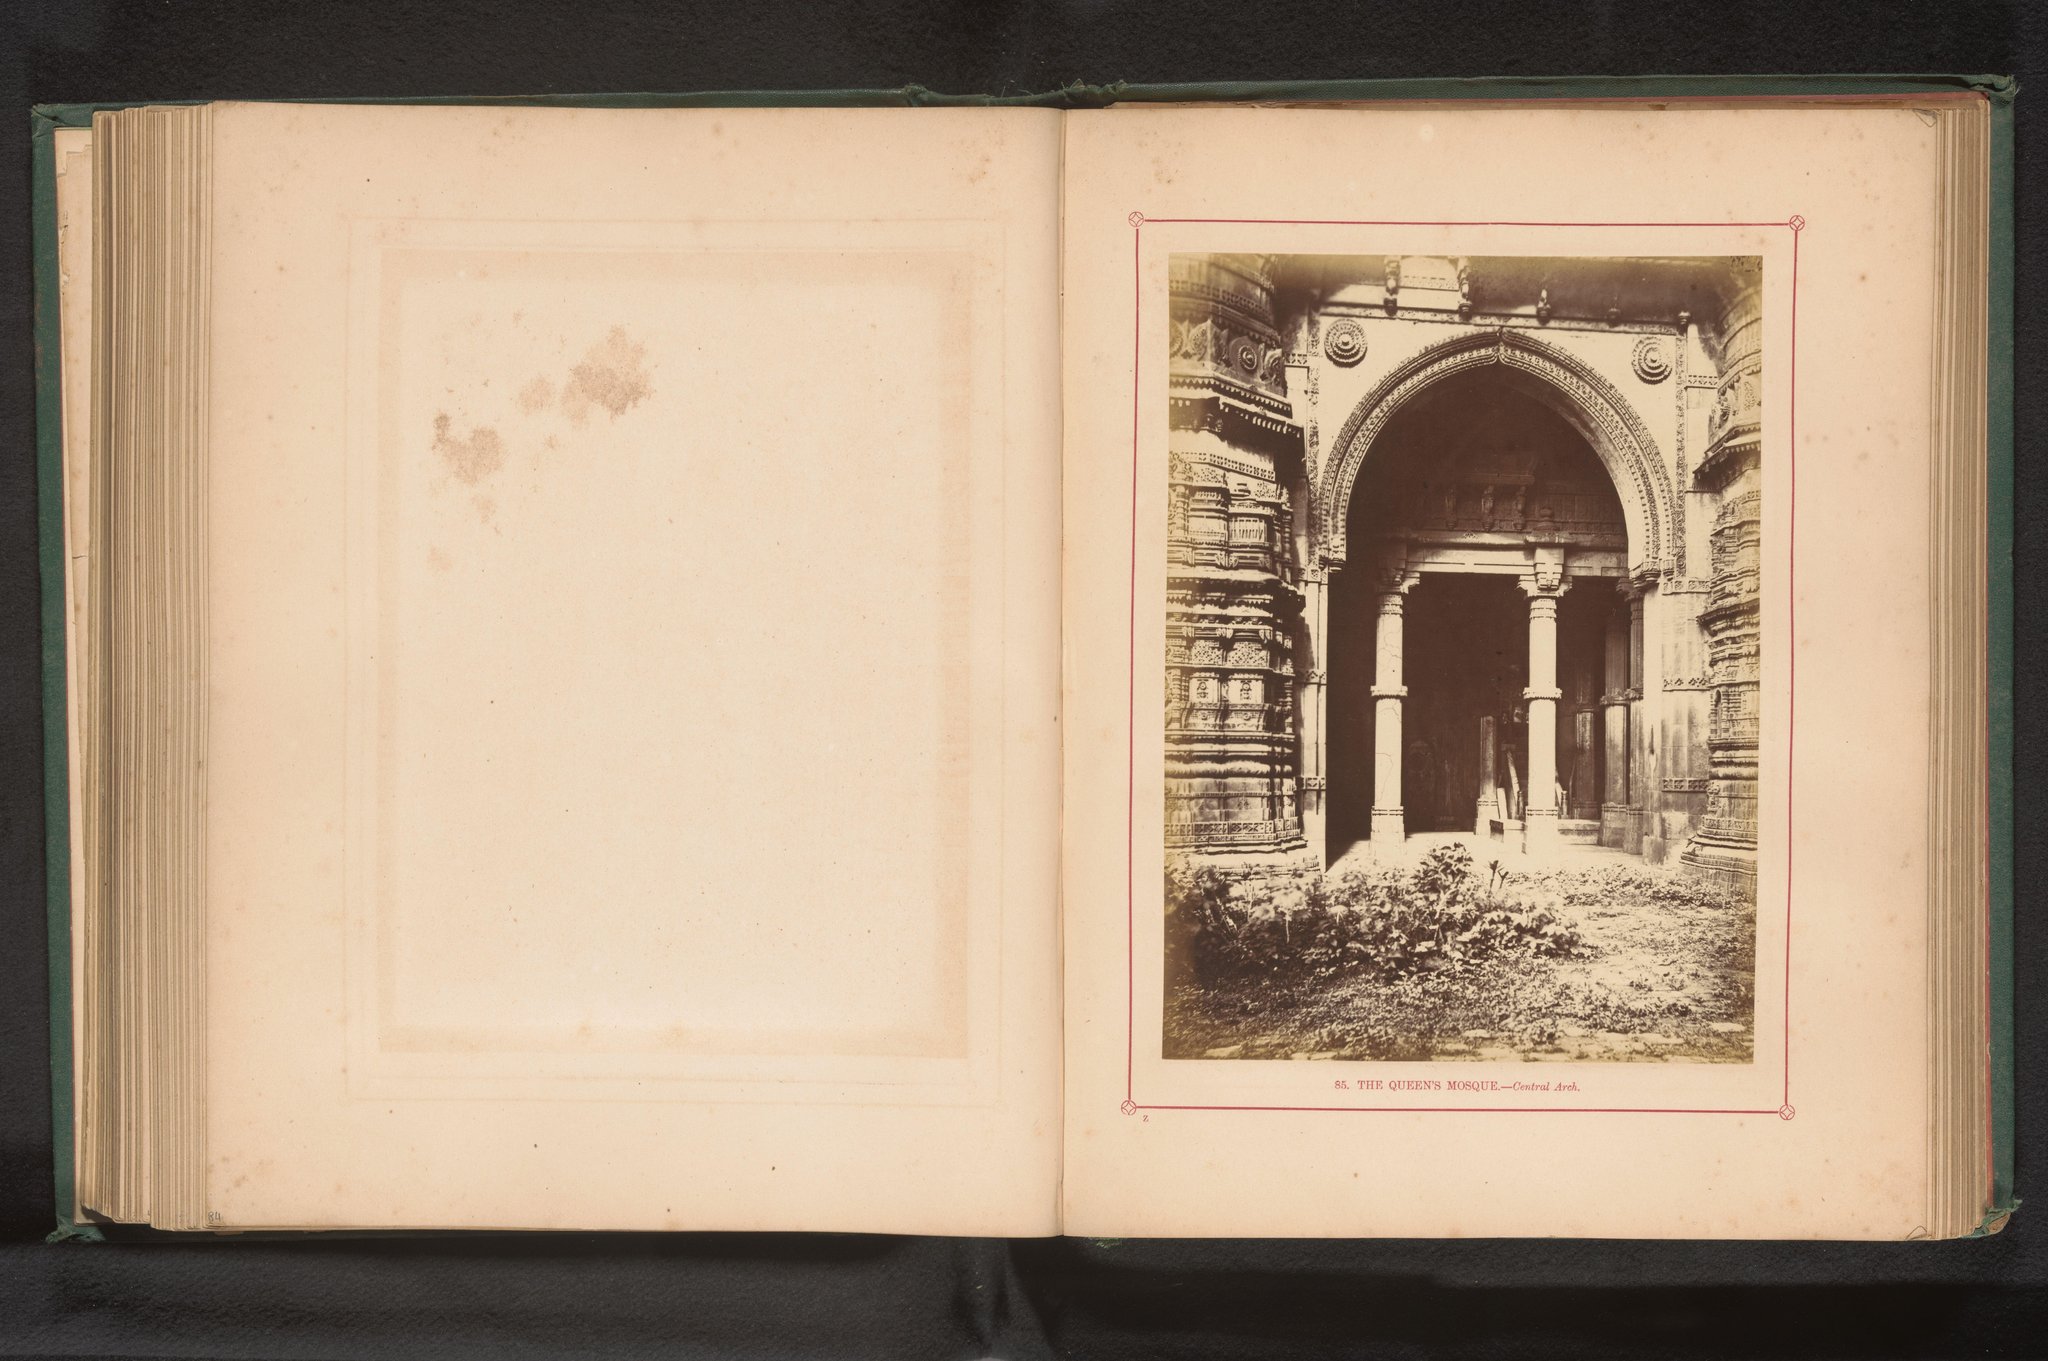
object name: page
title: The Queen's Mosque.- Central Arch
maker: thomas biggs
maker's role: fotograaf, kapitein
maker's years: 1822-1905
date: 1856-1866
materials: photographic support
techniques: albumen print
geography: ahmedabad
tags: temple, shrine ~ islam, mohammedanism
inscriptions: number: ‘85.’, inscription: ‘Z’